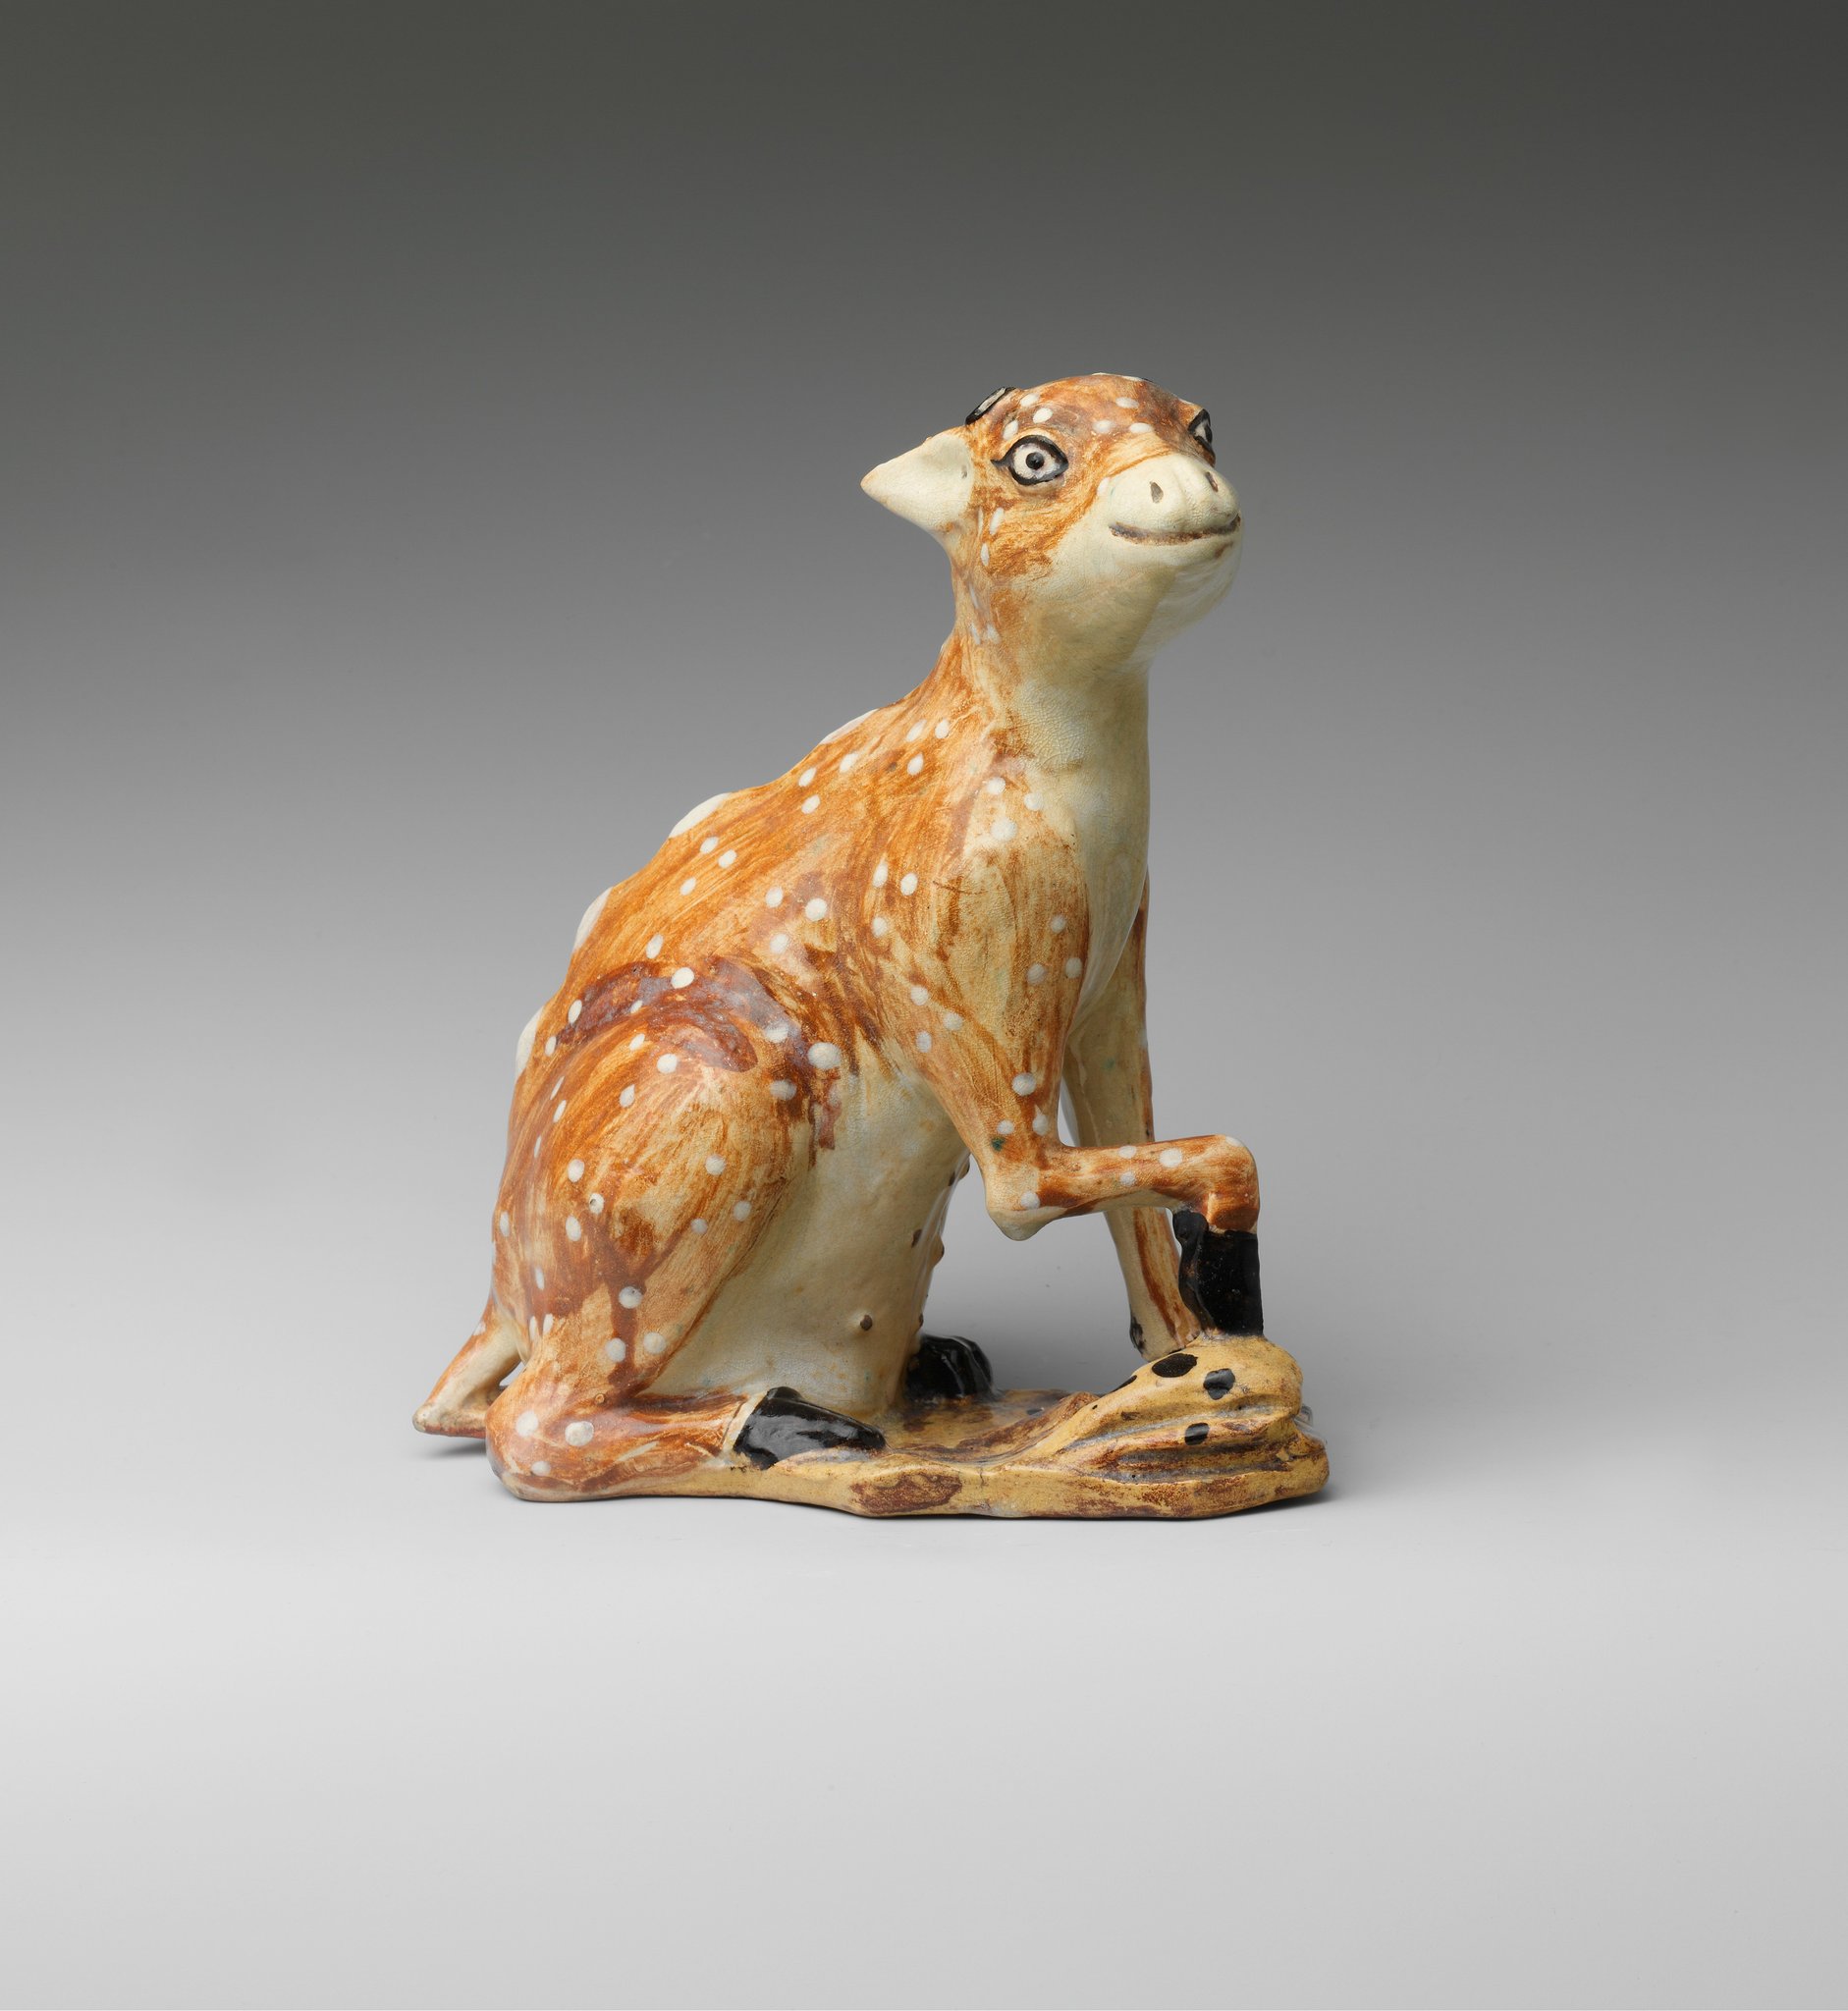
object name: figure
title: Deer Figure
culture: mexican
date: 1800-1900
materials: earthenware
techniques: glazing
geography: mexico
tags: deer